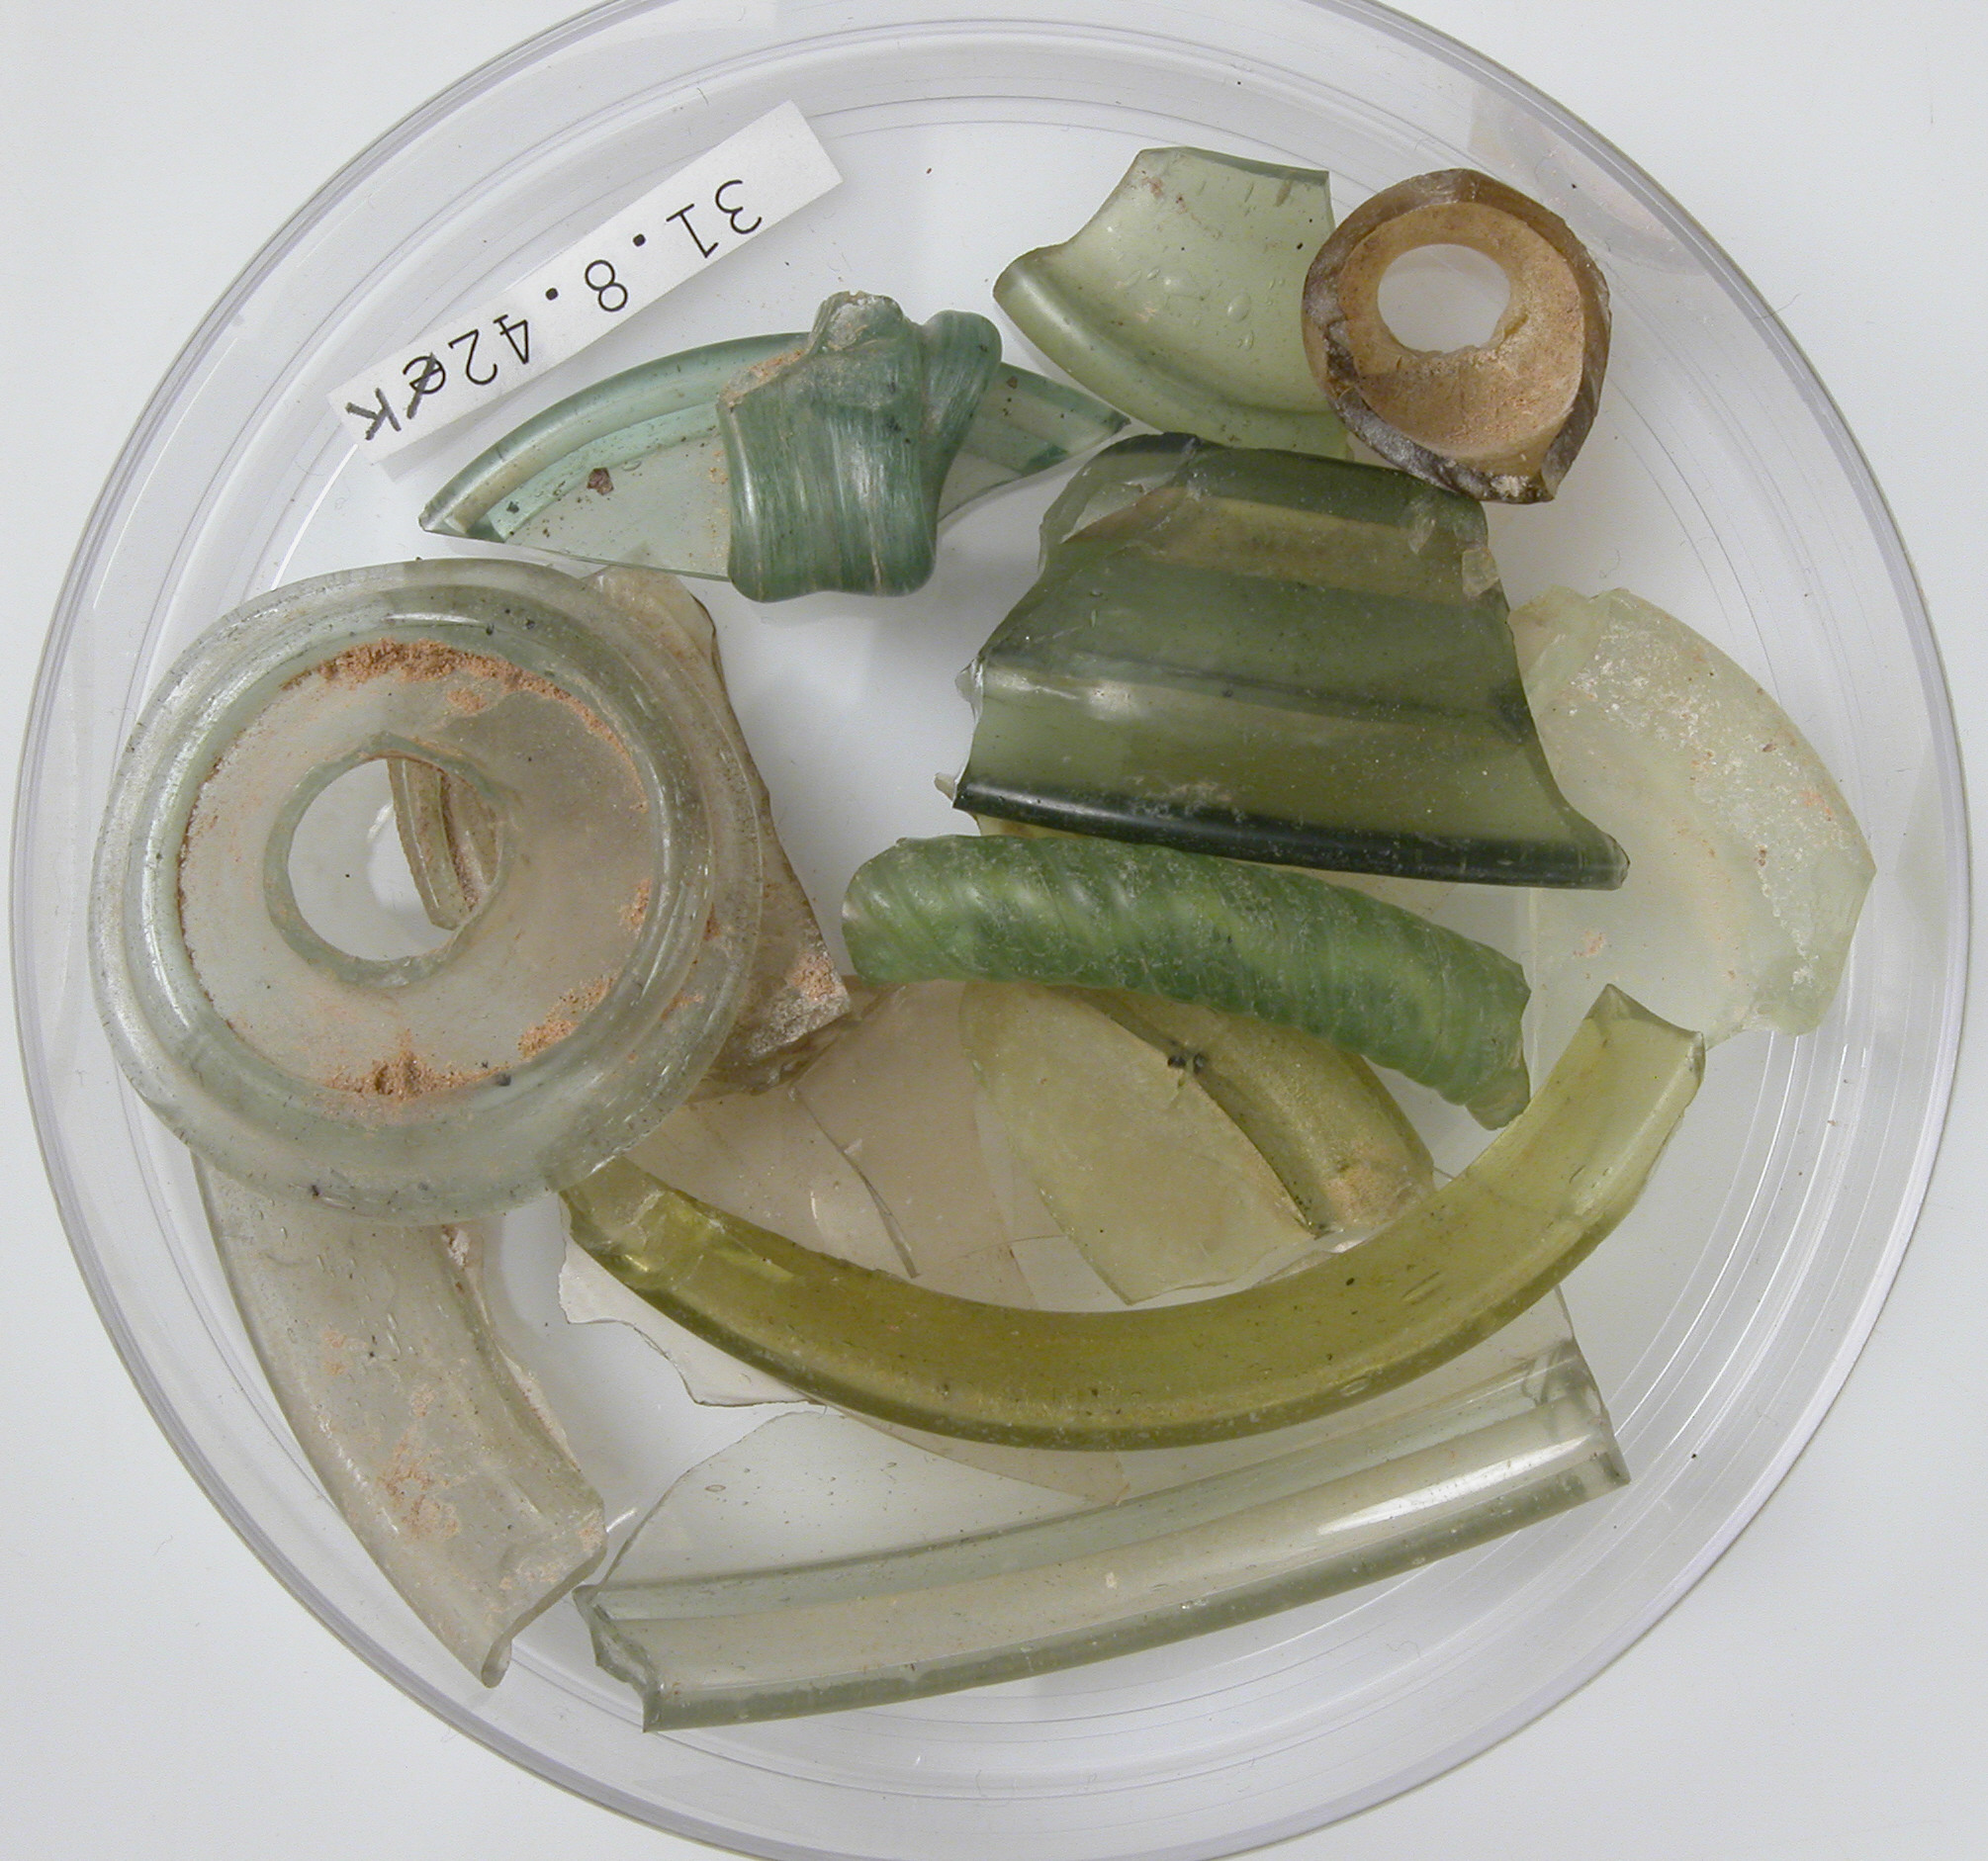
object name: fragment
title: Glass Fragments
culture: coptic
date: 301-400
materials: glass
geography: egypt